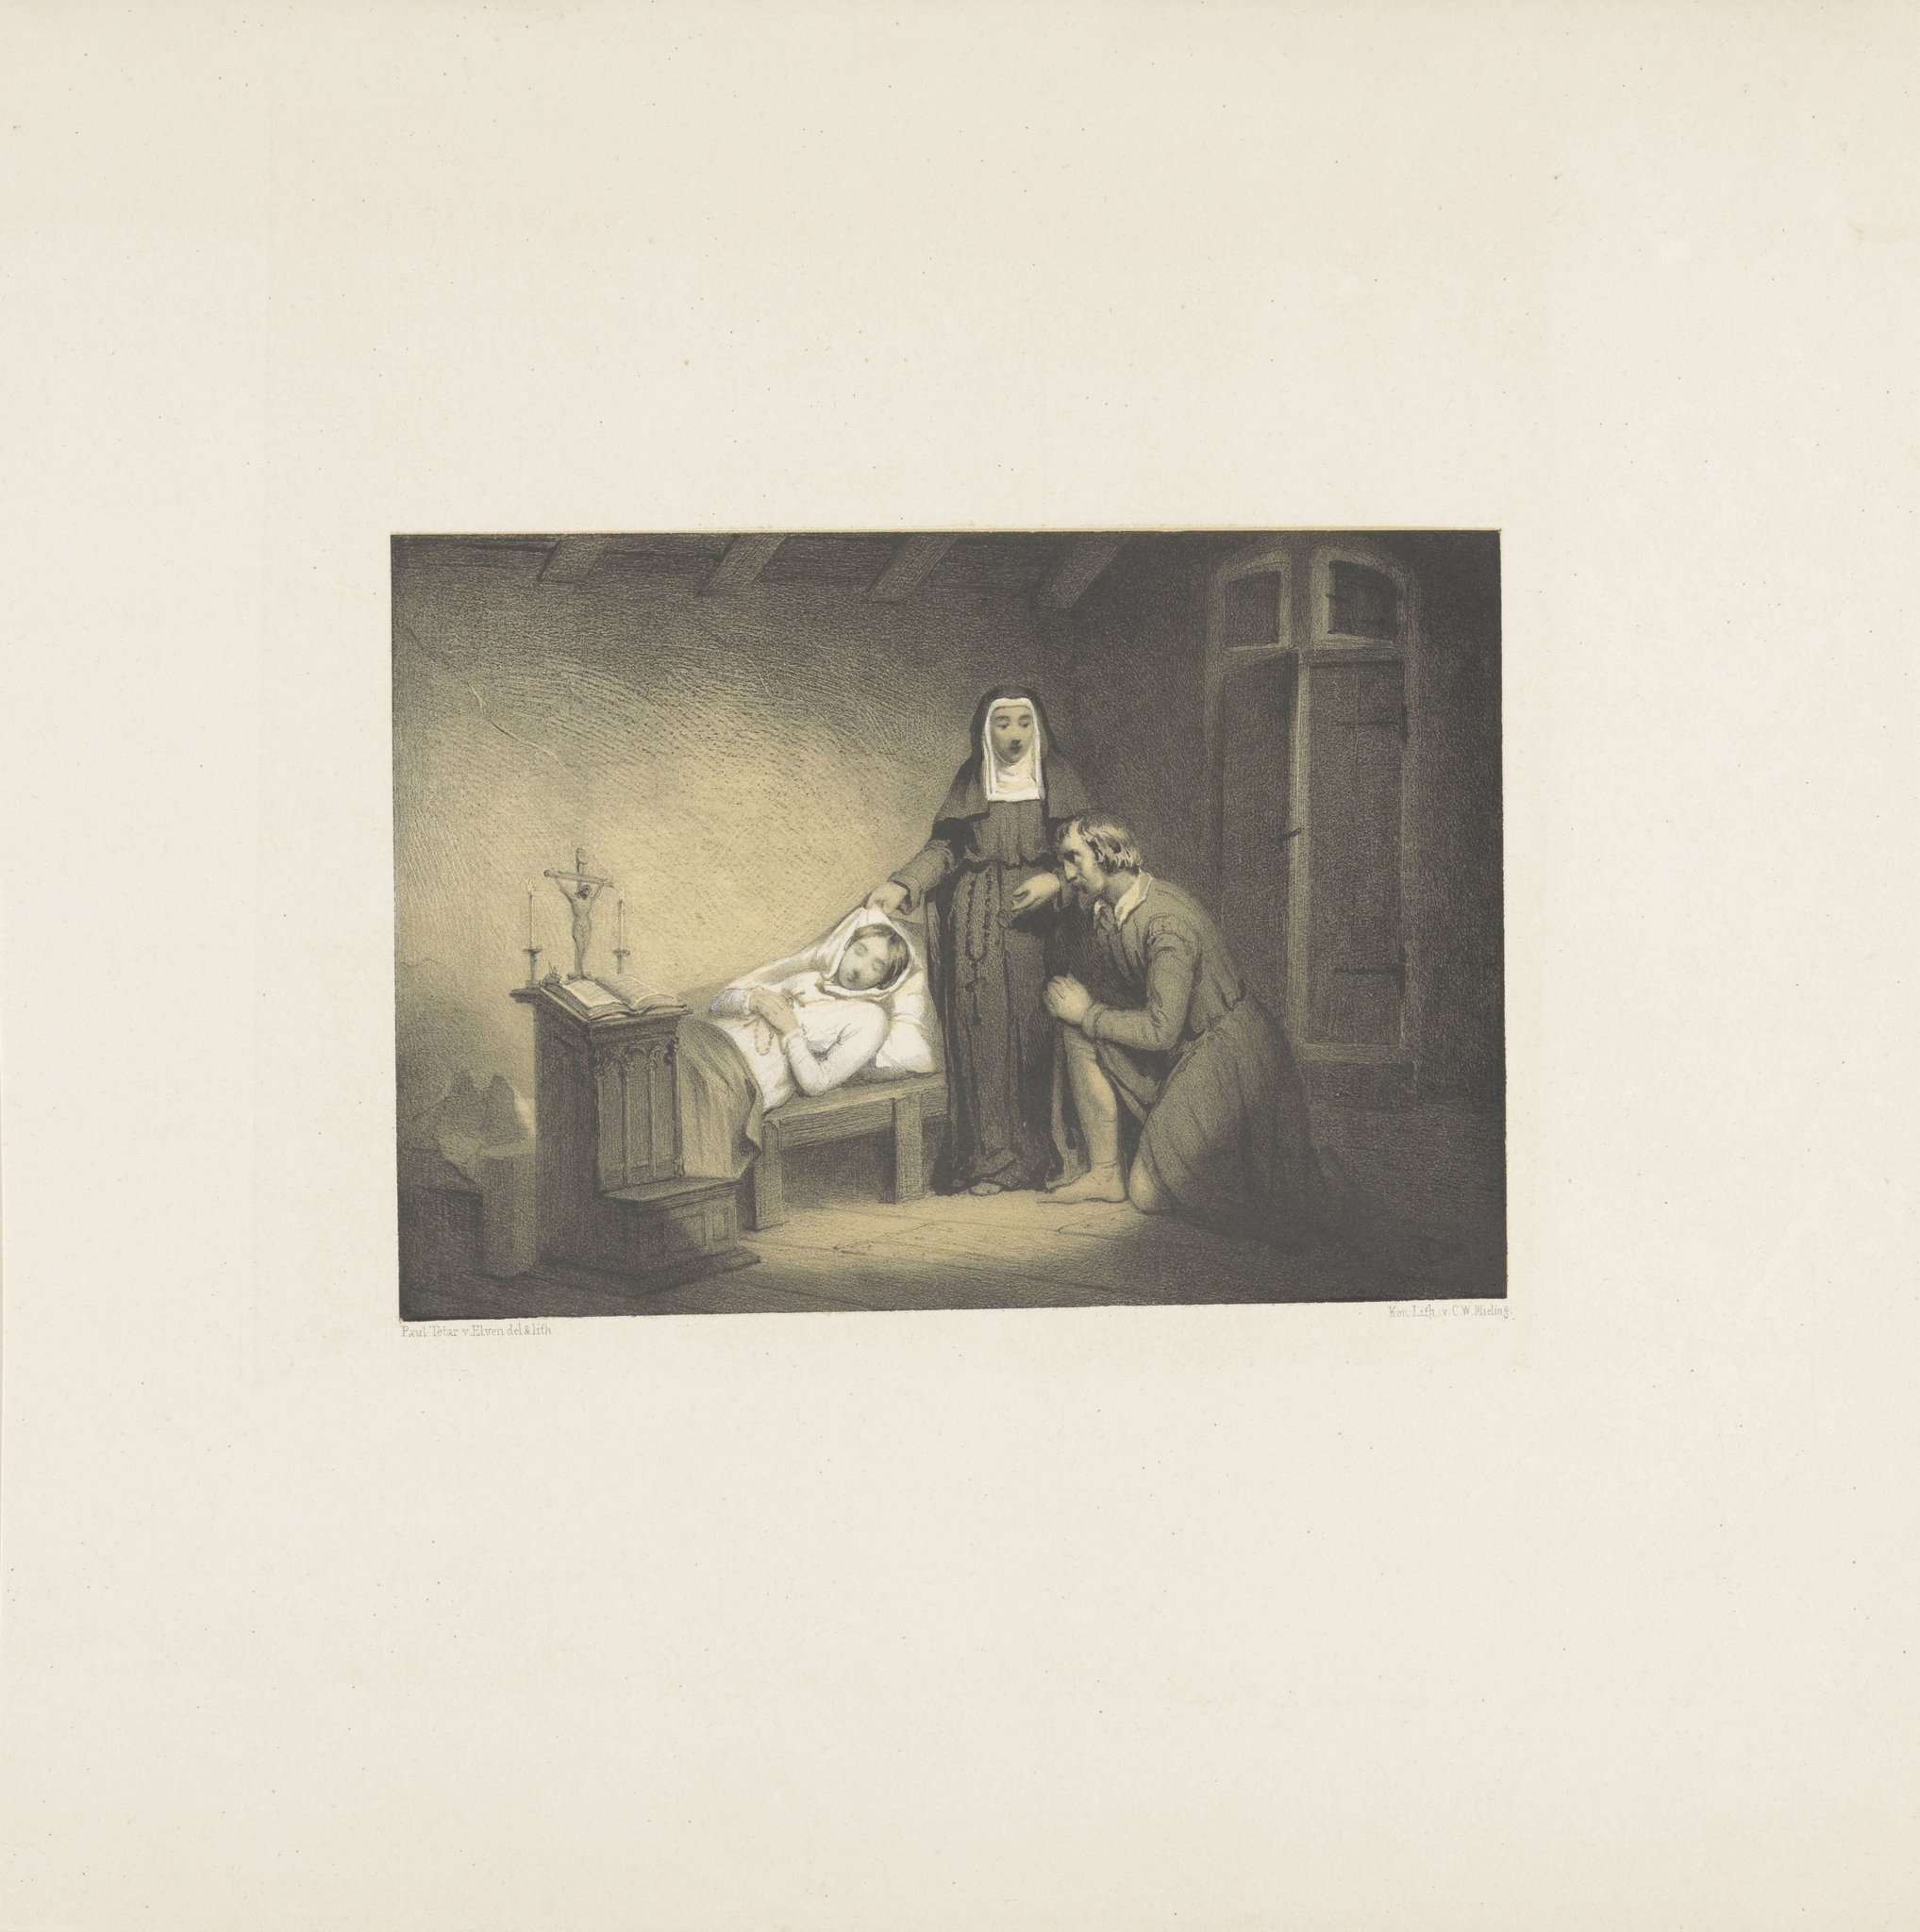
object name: print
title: Non en man bij overleden jongen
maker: paul tetar van elven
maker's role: print maker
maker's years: 1823-1896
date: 1833-1896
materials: paper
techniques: tone lithography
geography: the hague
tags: nun(s), deathbed, one person praying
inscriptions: collector's mark: Lugt 2228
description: De jongen ligt in bed, draagt een wit gewaad en heeft een kruis met rozenkrans in zijn handen. De non staat naast hem, de man zit geknield en bidt. Aan het voeteneind staat een knielbank met daarop een opengeslagen bijbel, kaarsen en een crucifix.